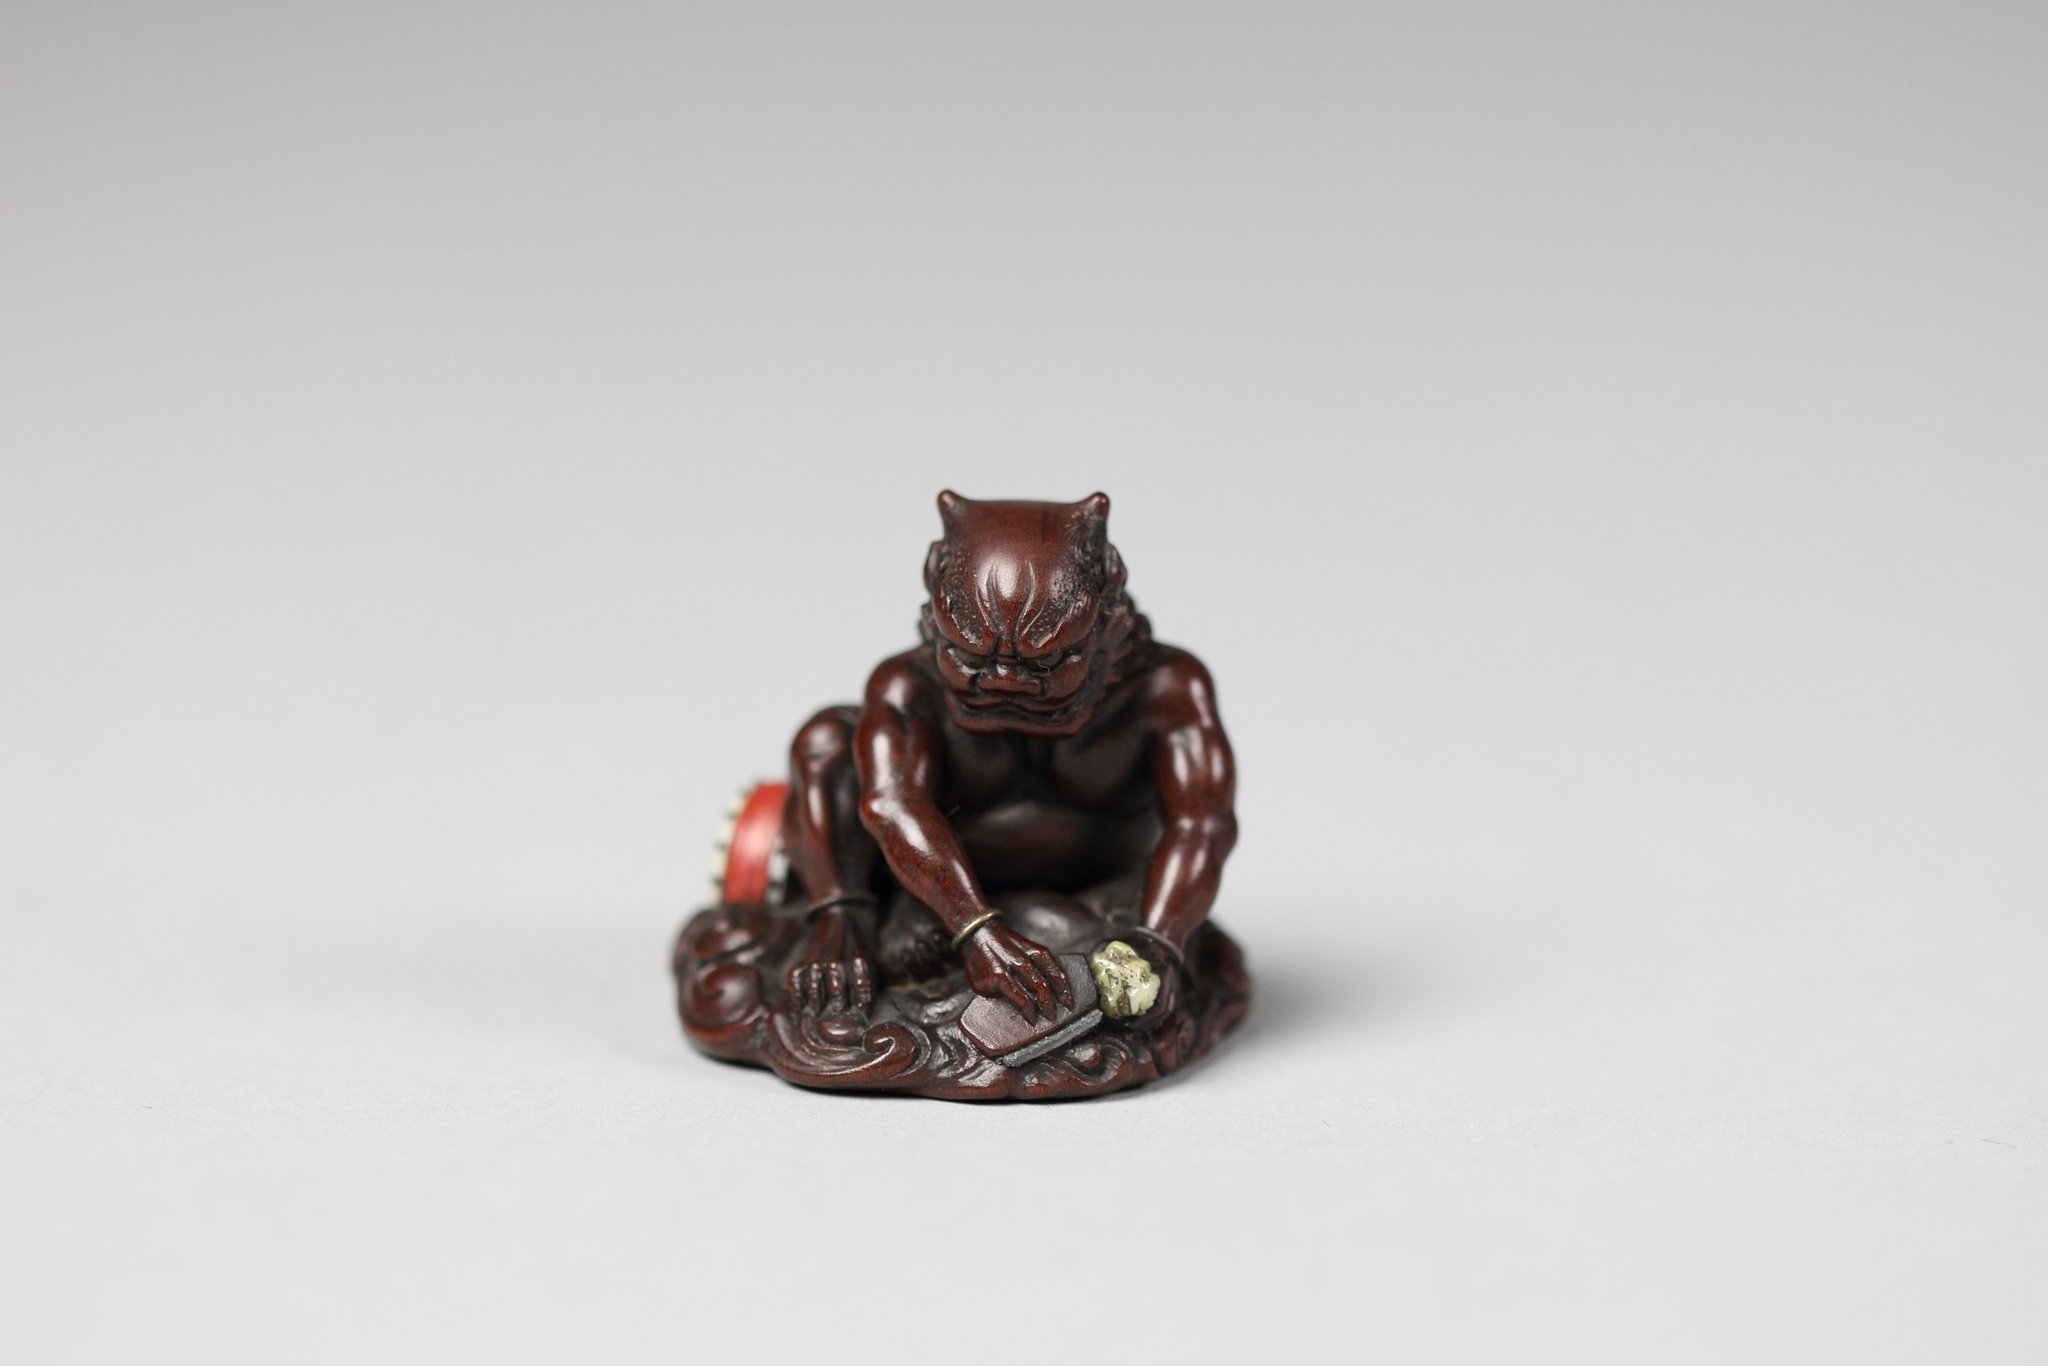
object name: netsuke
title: Netsuke of Demon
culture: japanese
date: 1801-1900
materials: ivory, wood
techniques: inlay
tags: demons